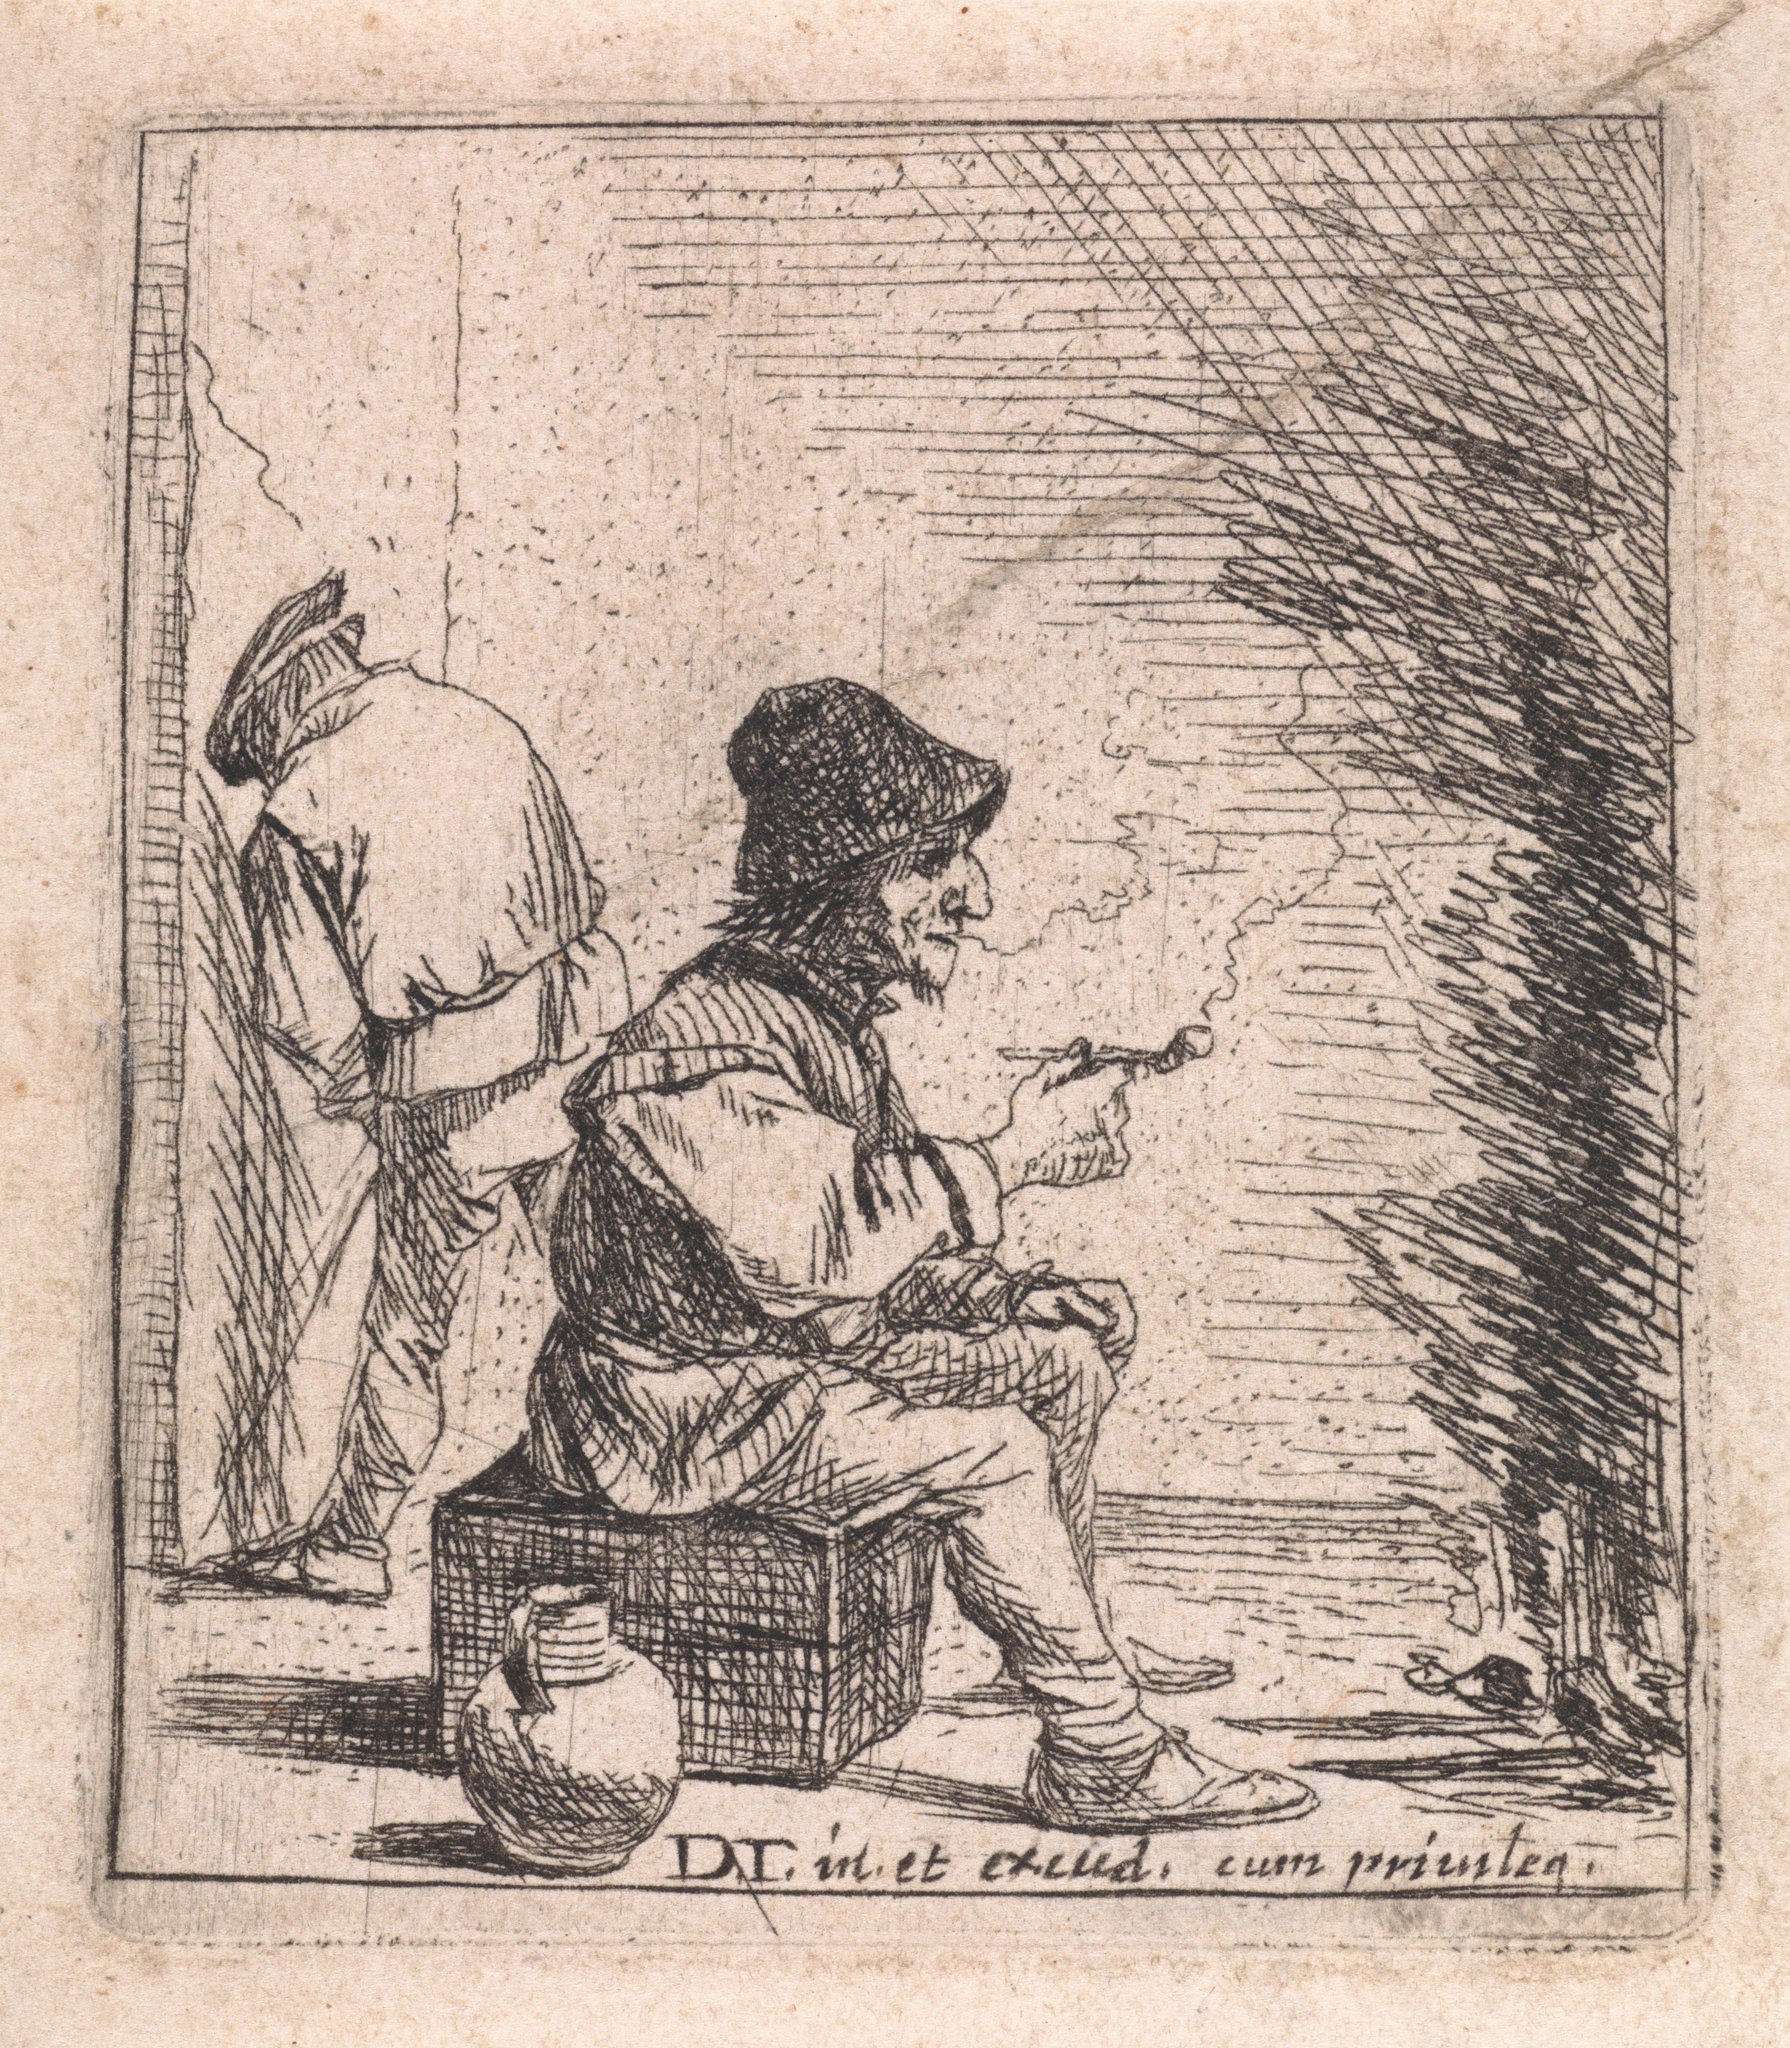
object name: print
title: Rokende boer bij het vuur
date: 1626-1690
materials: paper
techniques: etching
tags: pipe ~ tobacco, open hearth, fire-place, urination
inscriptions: collector's mark: Lugt 2228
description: Een boer rookt zijn pijp bij het vuur. Links urineert een man in de hoek.